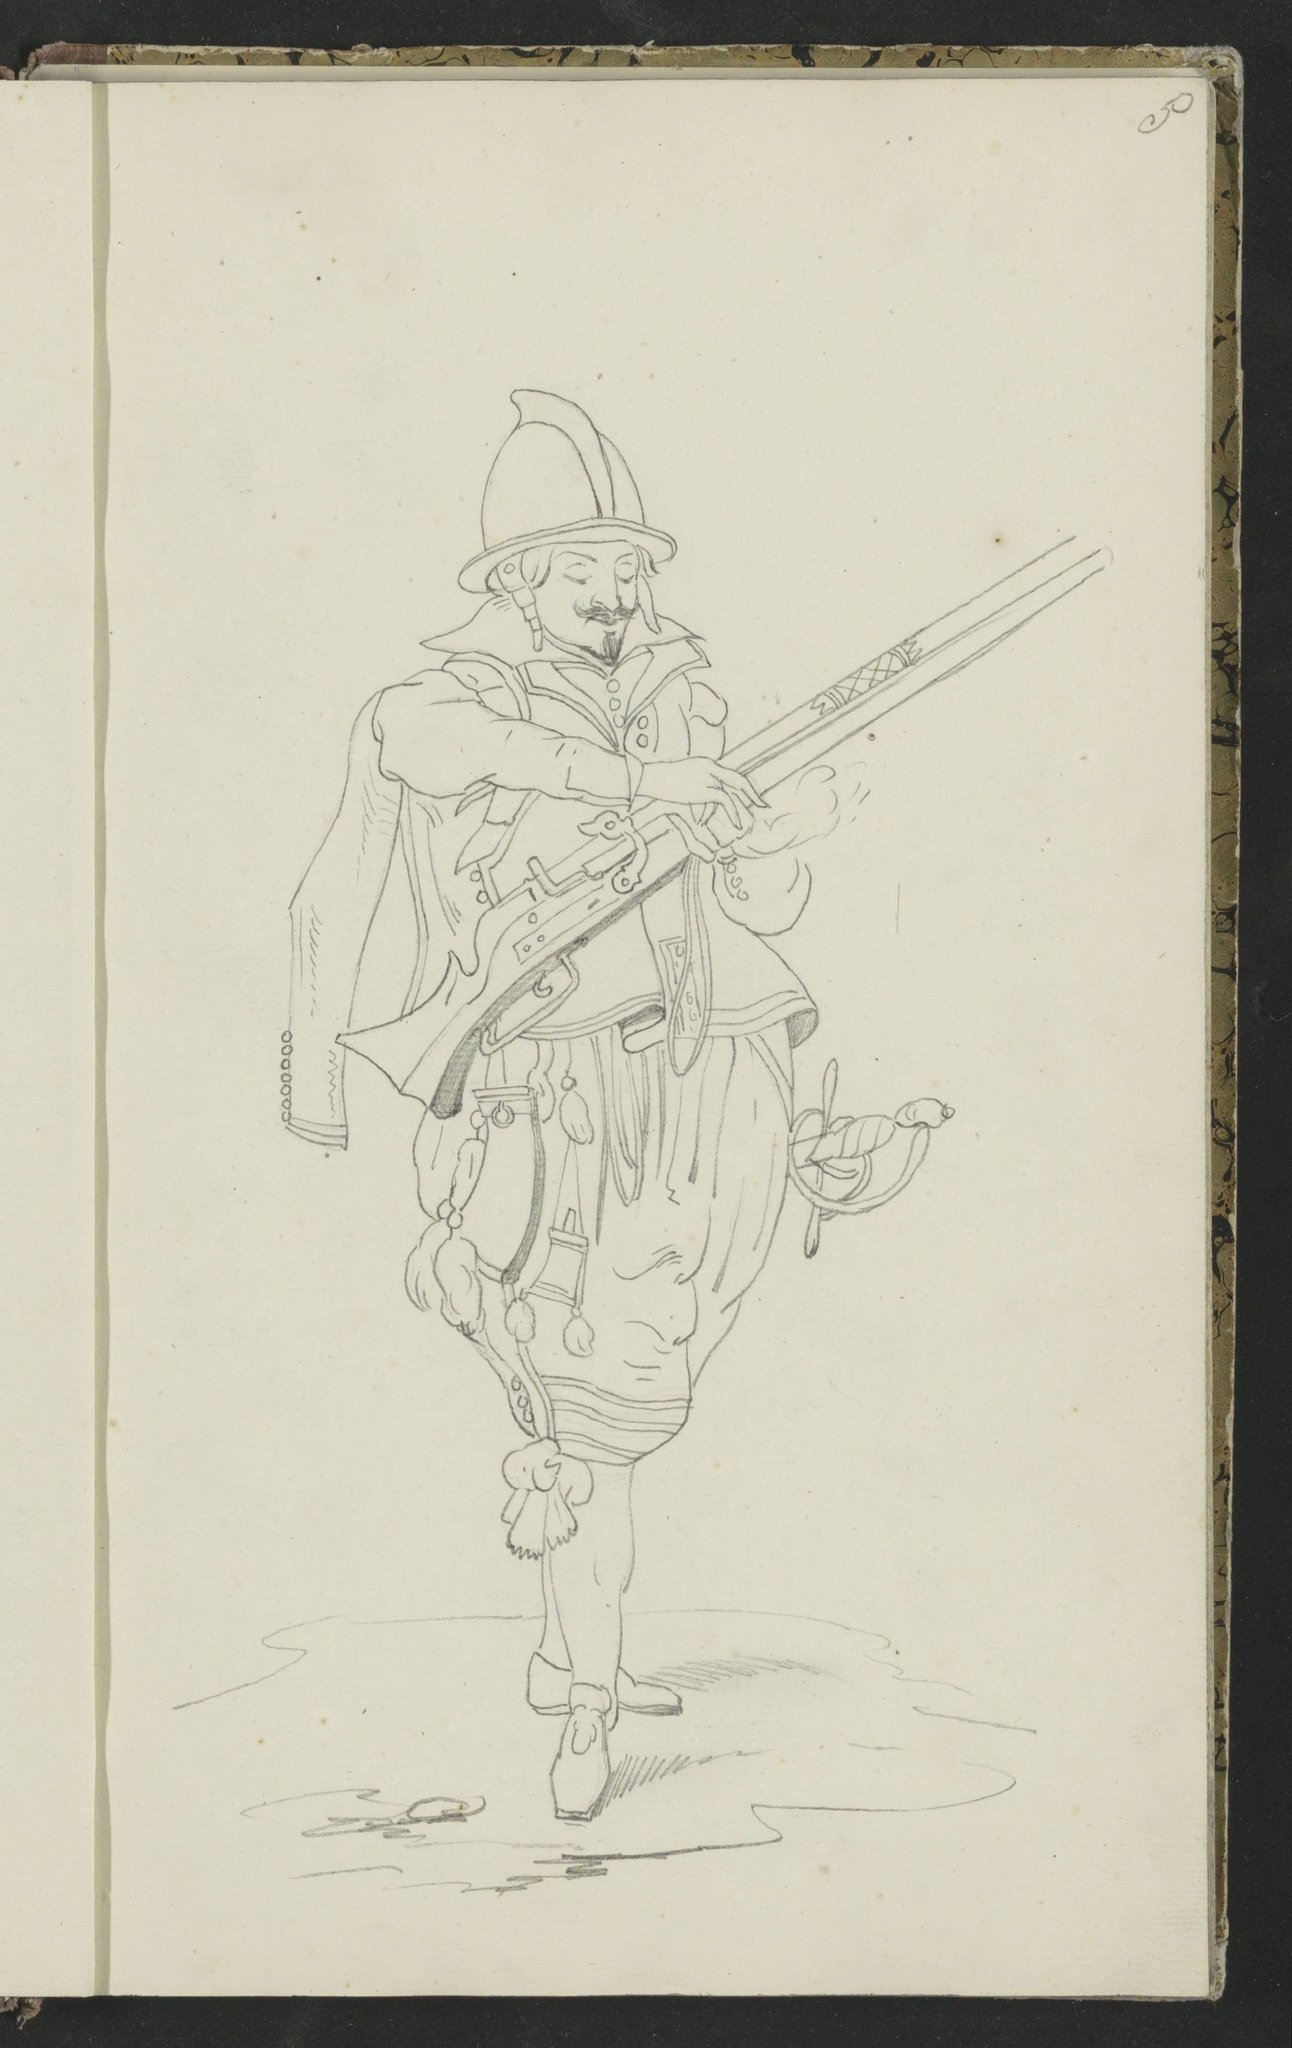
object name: sketchbook leaf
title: Soldaat met een musket die zijn lont pakt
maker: johannes antonius canta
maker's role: draughtsman, painter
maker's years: 1816-1888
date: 1826-1888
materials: paper, pencil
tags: firearms, (military) uniforms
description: Kopie naar Jacob de Gheyns 'Wapenhandelinghe van roers musquetten ende spiessen: achtervolghende de ordre van syn excellentie Maurits prince van Orangie grave van Nassau &c' uit 1607. Blad 5 recto uit een schetsboek en album met 59 bladen.